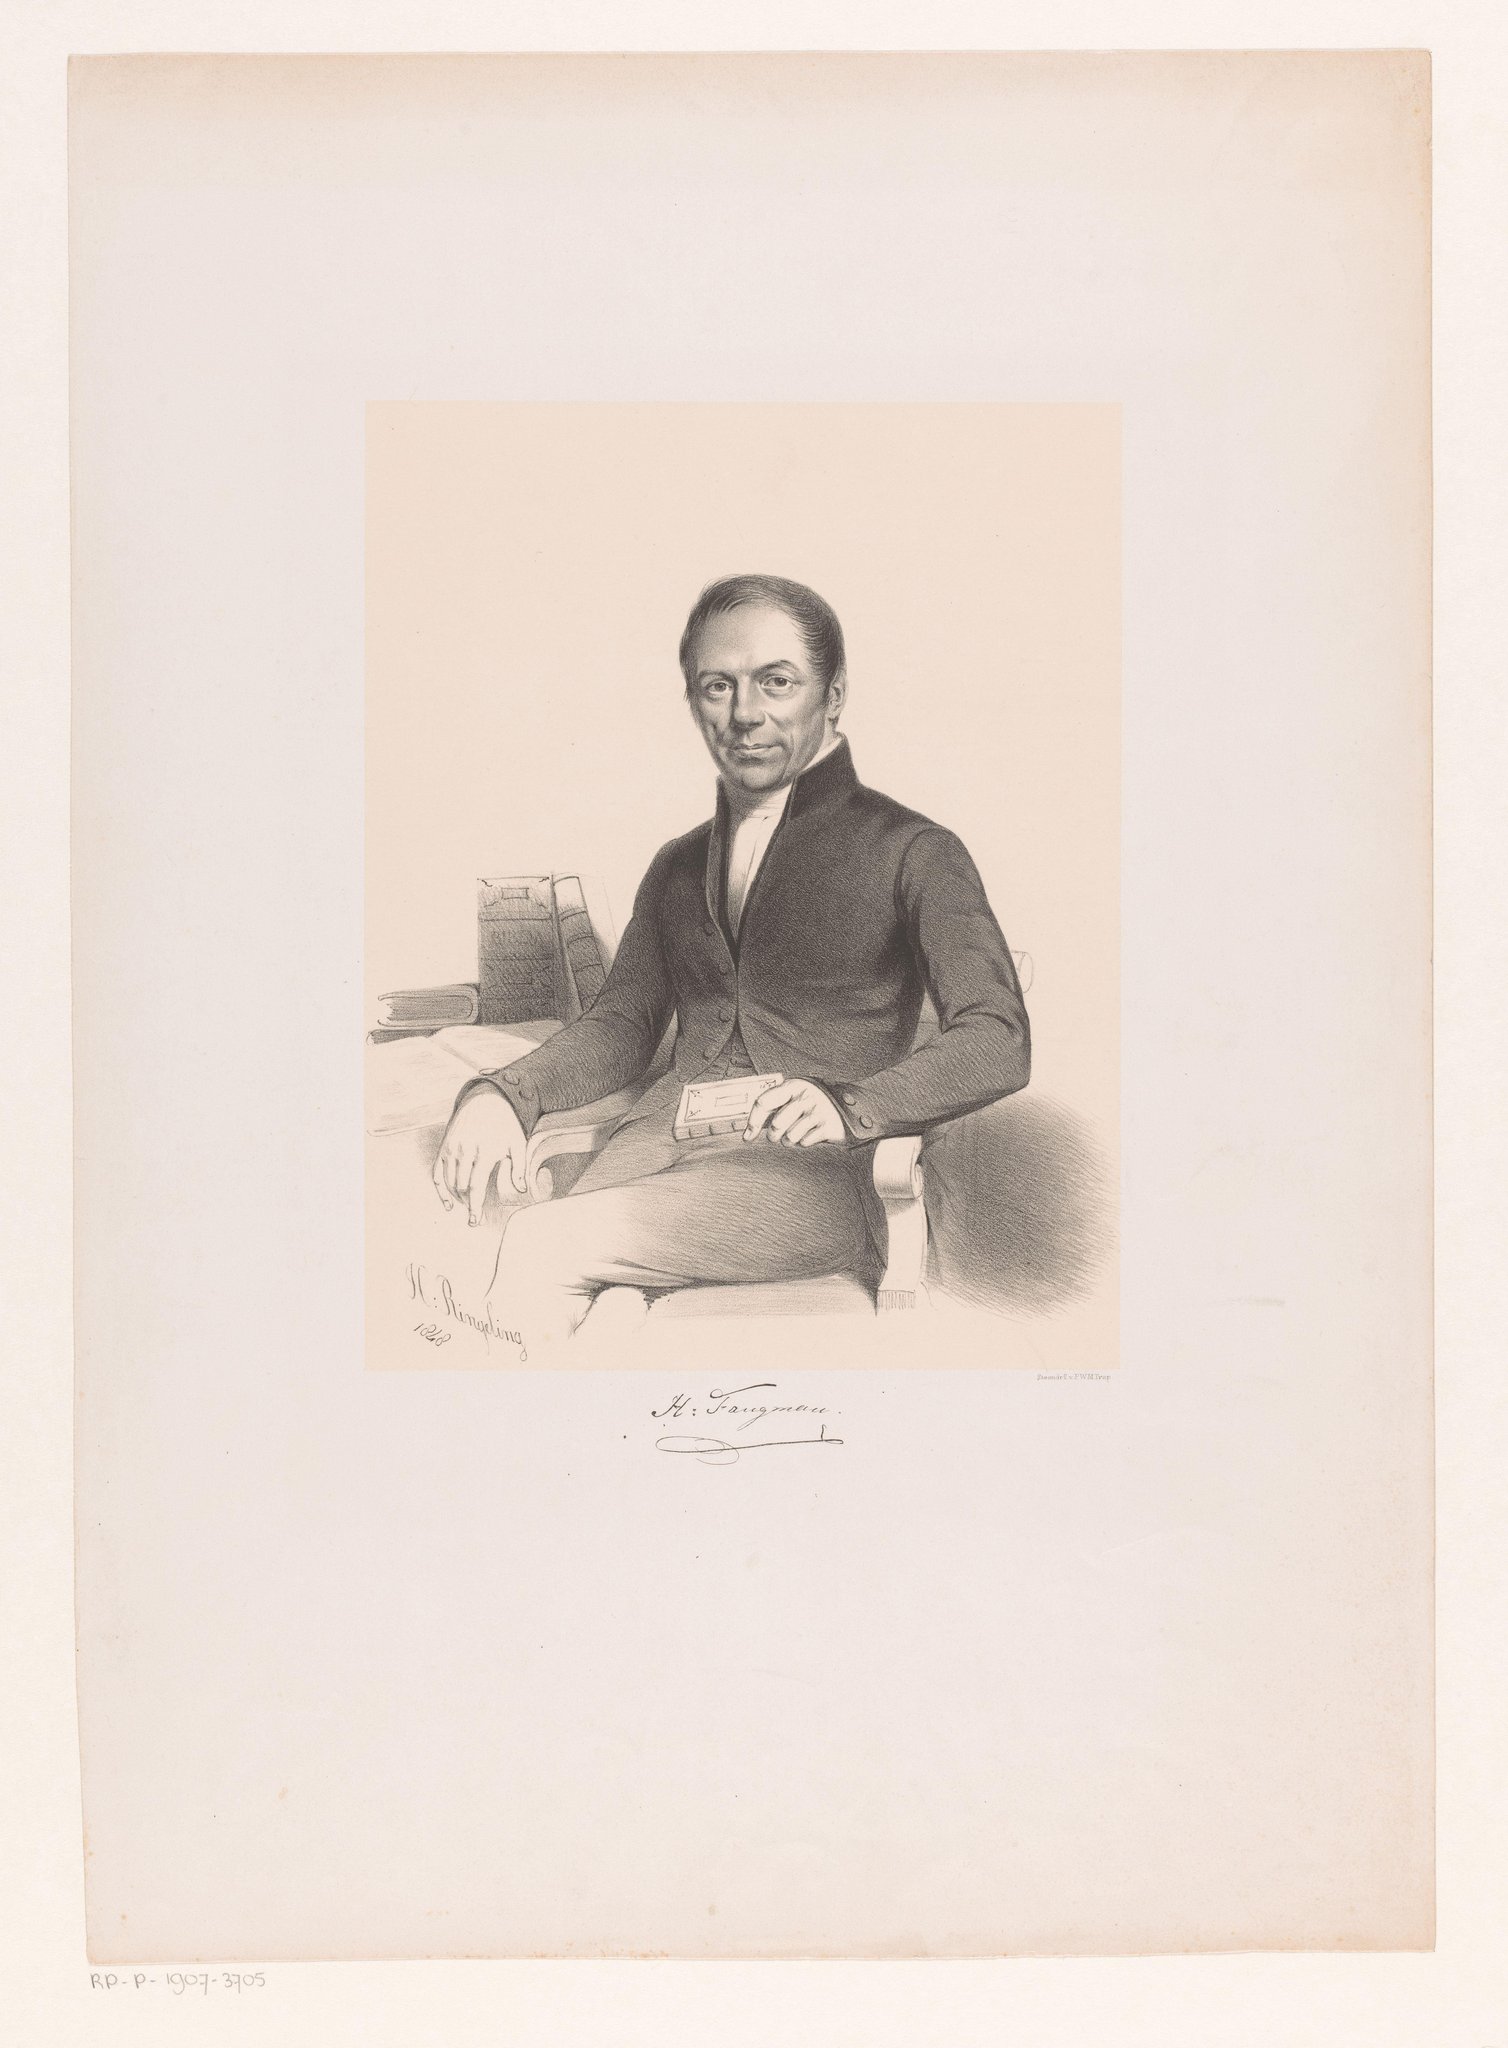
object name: print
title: H. Fangman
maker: pieter willem marinus trap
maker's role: print maker, printer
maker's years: 1821-1905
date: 1848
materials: paper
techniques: lithograph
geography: leiden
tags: hoorn (north holland), historical persons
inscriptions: collector's mark: Lugt 2228